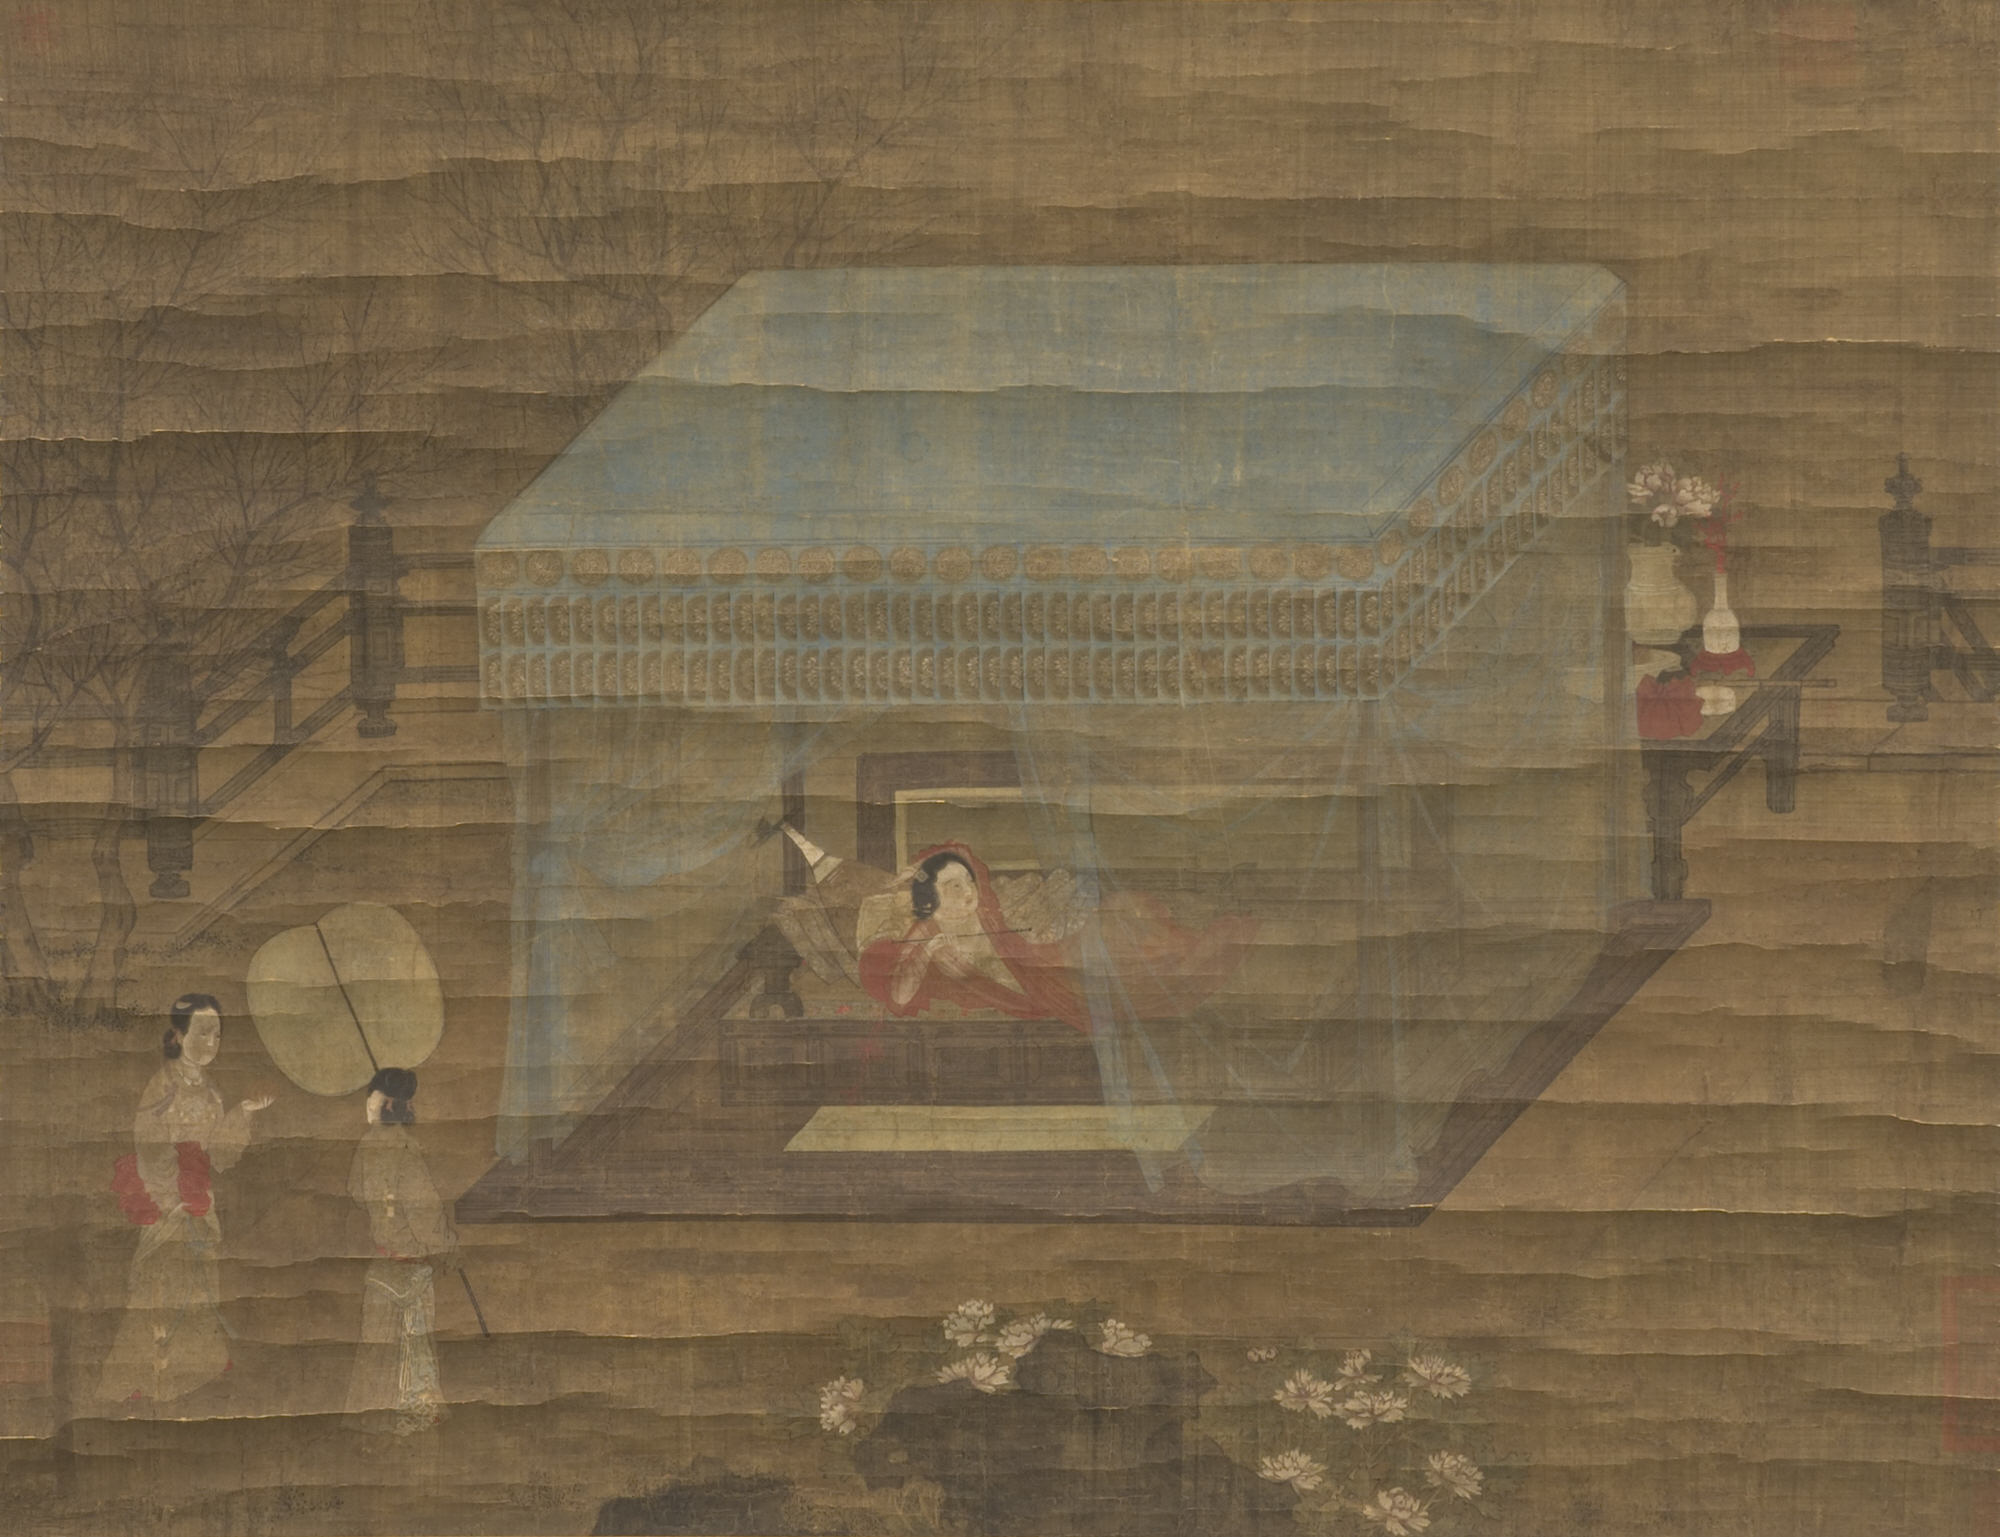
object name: hanging scroll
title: A Beauty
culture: chinese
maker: unidentified artist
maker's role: artist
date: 1368-1911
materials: ink, silk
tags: tents,women,beds,pavilions